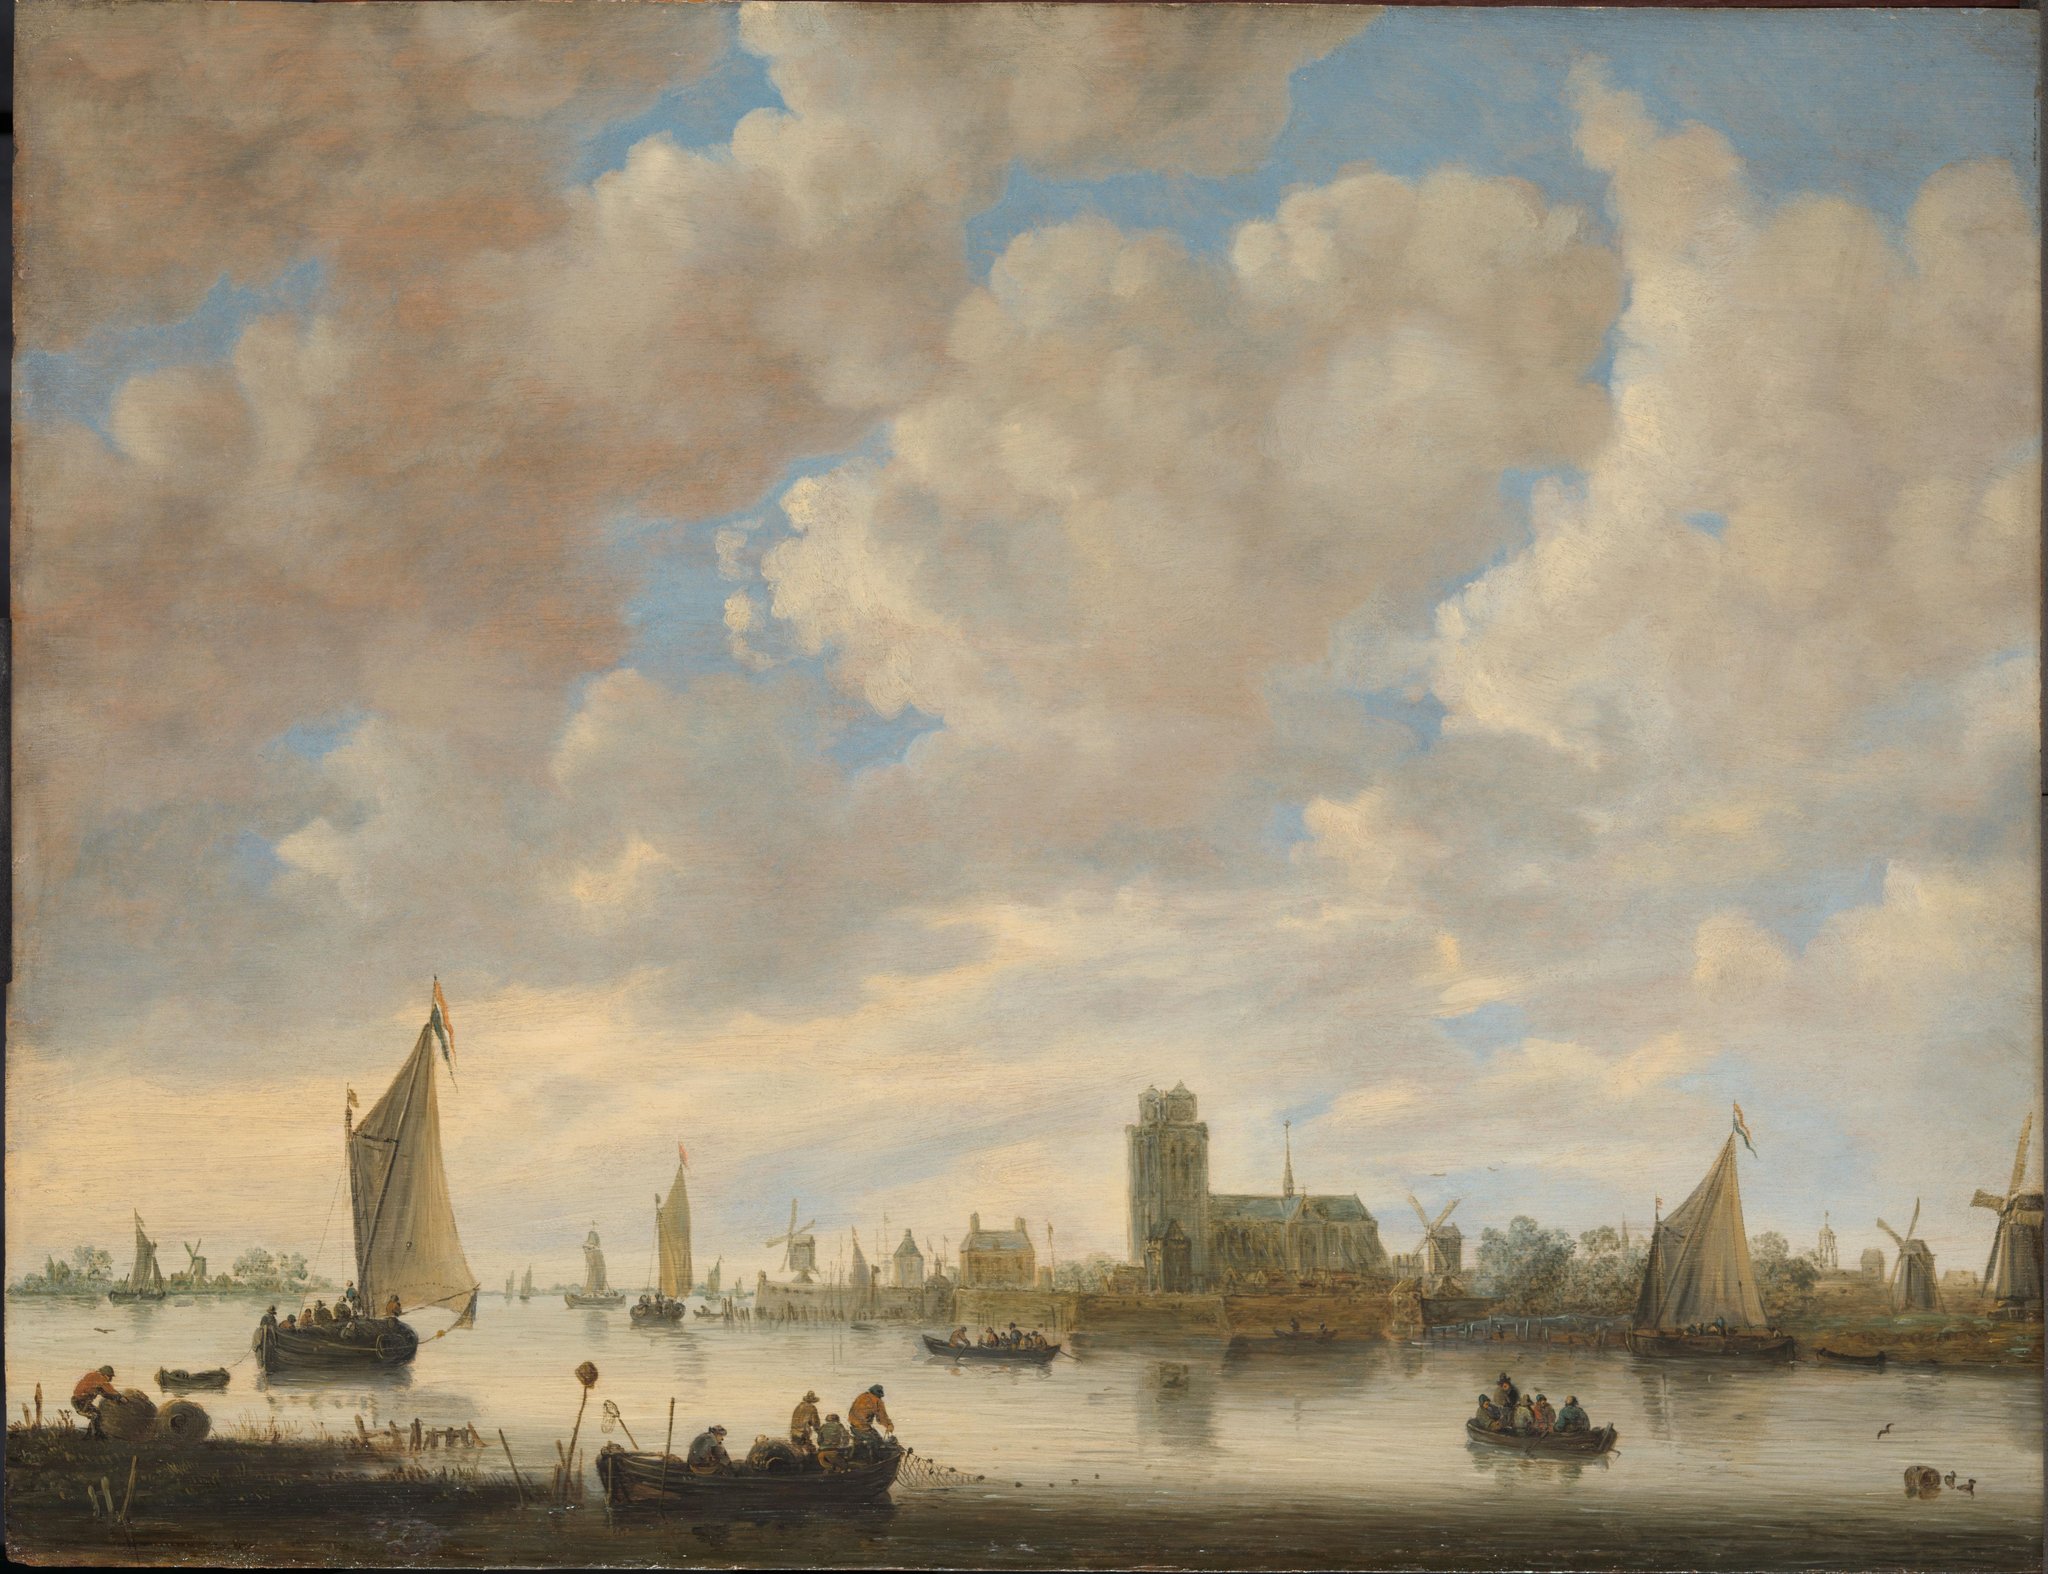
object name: painting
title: View of the Merwede off Dordrecht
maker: jeronymus van diest (ii)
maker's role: painter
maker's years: 1631-1677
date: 1660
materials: oil, panel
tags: sailing-ship, sailing-boat, river, rowing-boat, canoe, etc., prospect of city, town panorama, silhouette of city, dordrecht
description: Gezicht op de Merwede voor Dordrecht. In de verte de toren van de Grote Kerk en verschillende molens op de stadswallen. Nabij de oever op de voorgrond halen vissers hun netten binnen, op het water varen allerlei kleine roeiboten en zeilschepen.